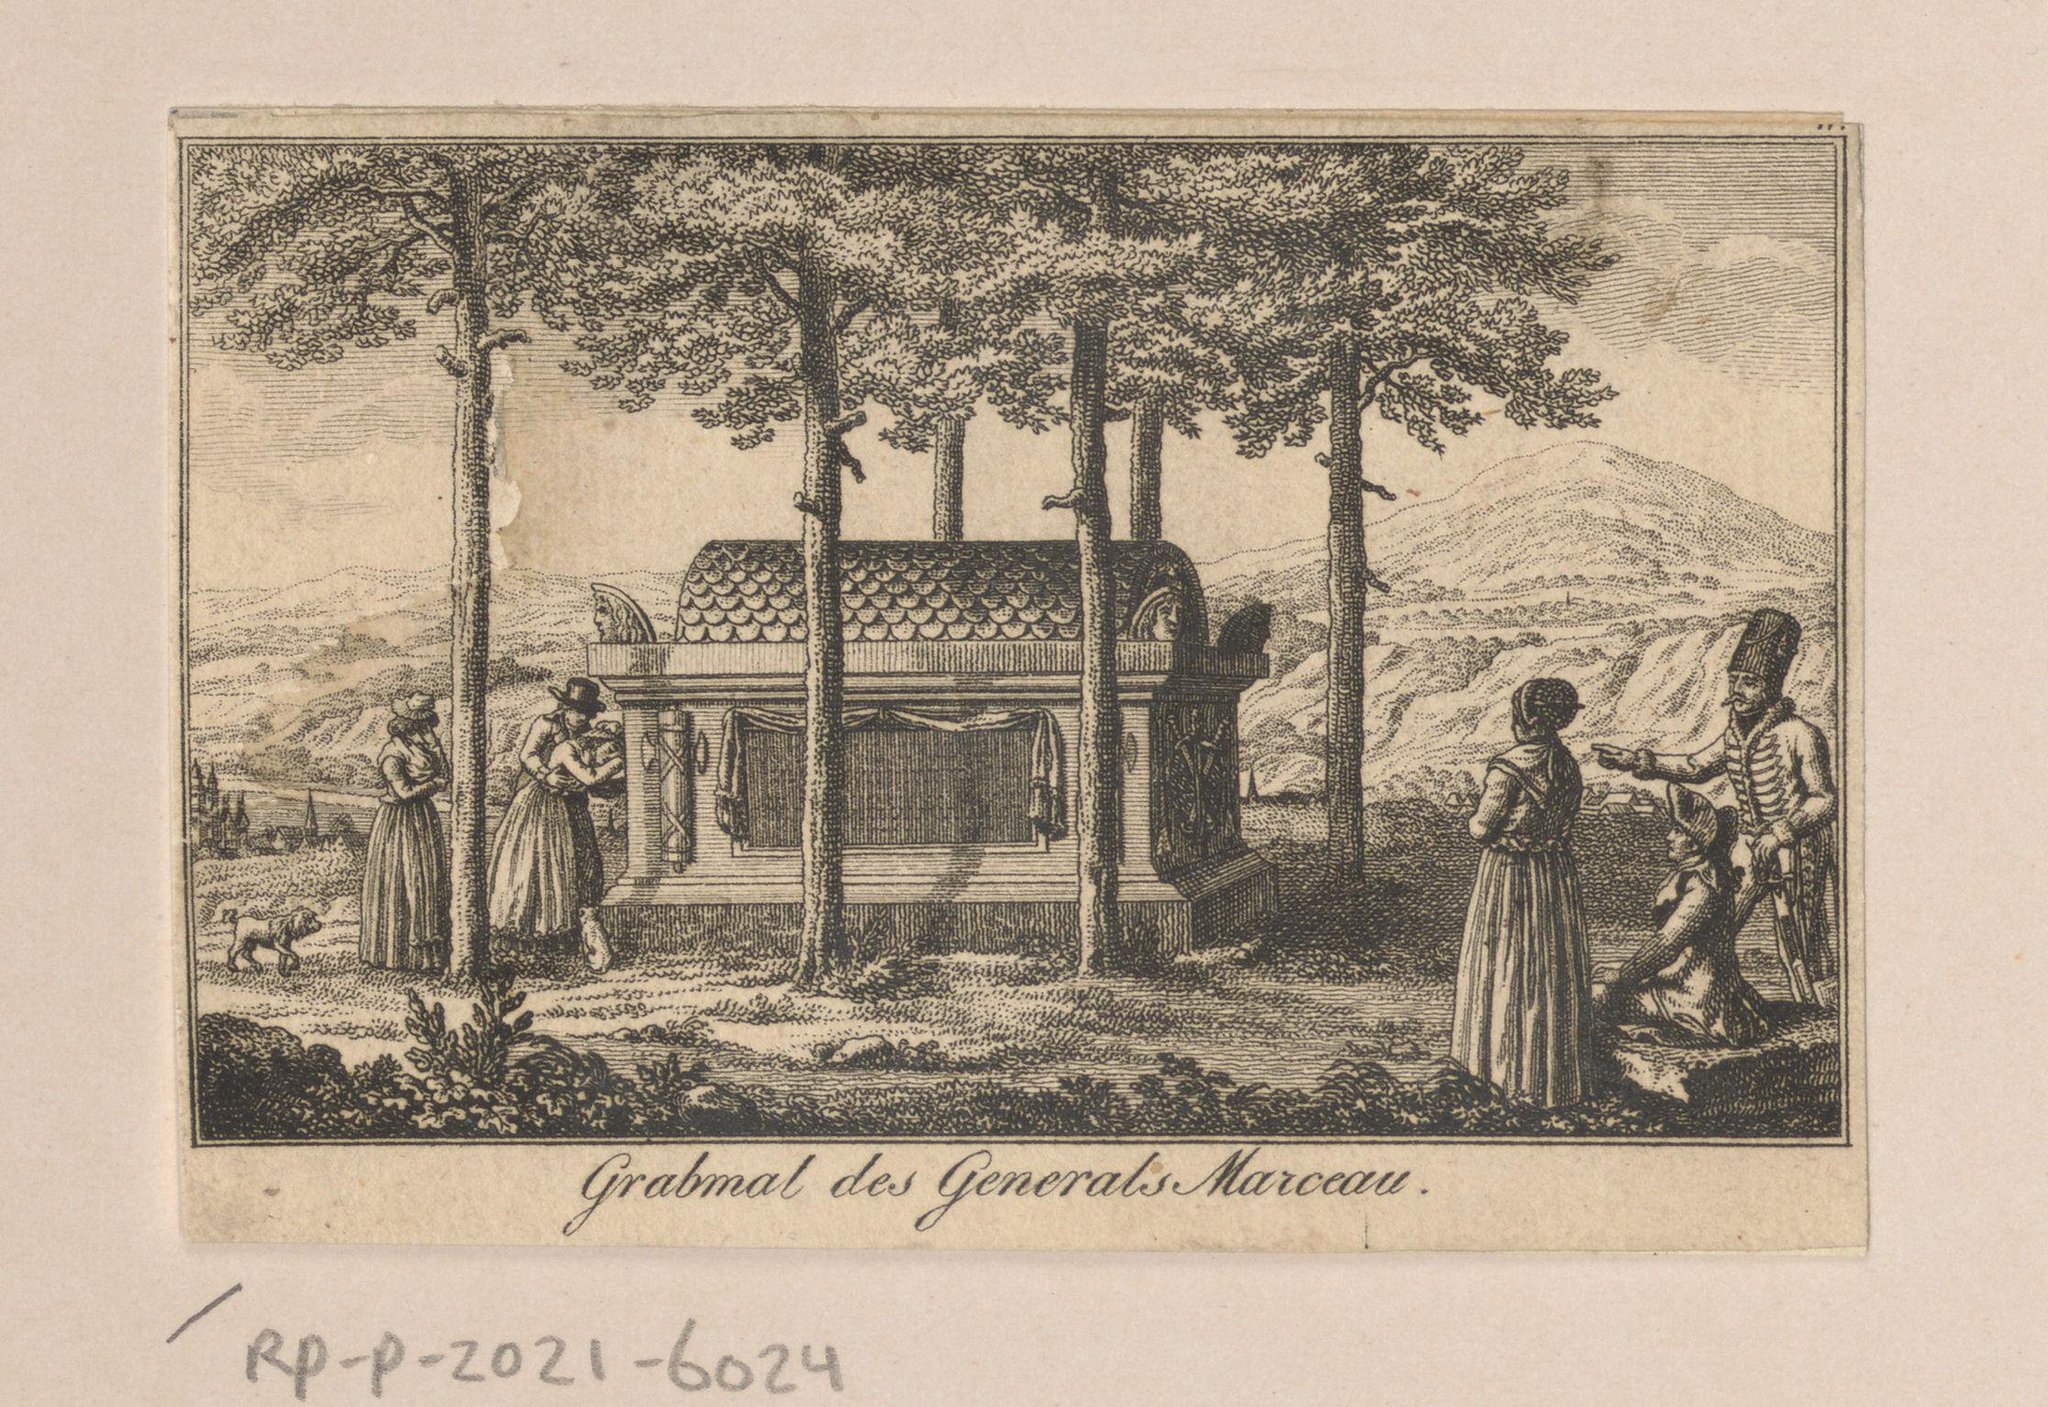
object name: print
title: Grabmal des Generals Marceau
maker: Anonymous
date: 1796-1830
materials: paper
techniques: etching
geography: germany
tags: historical persons, grave, tomb